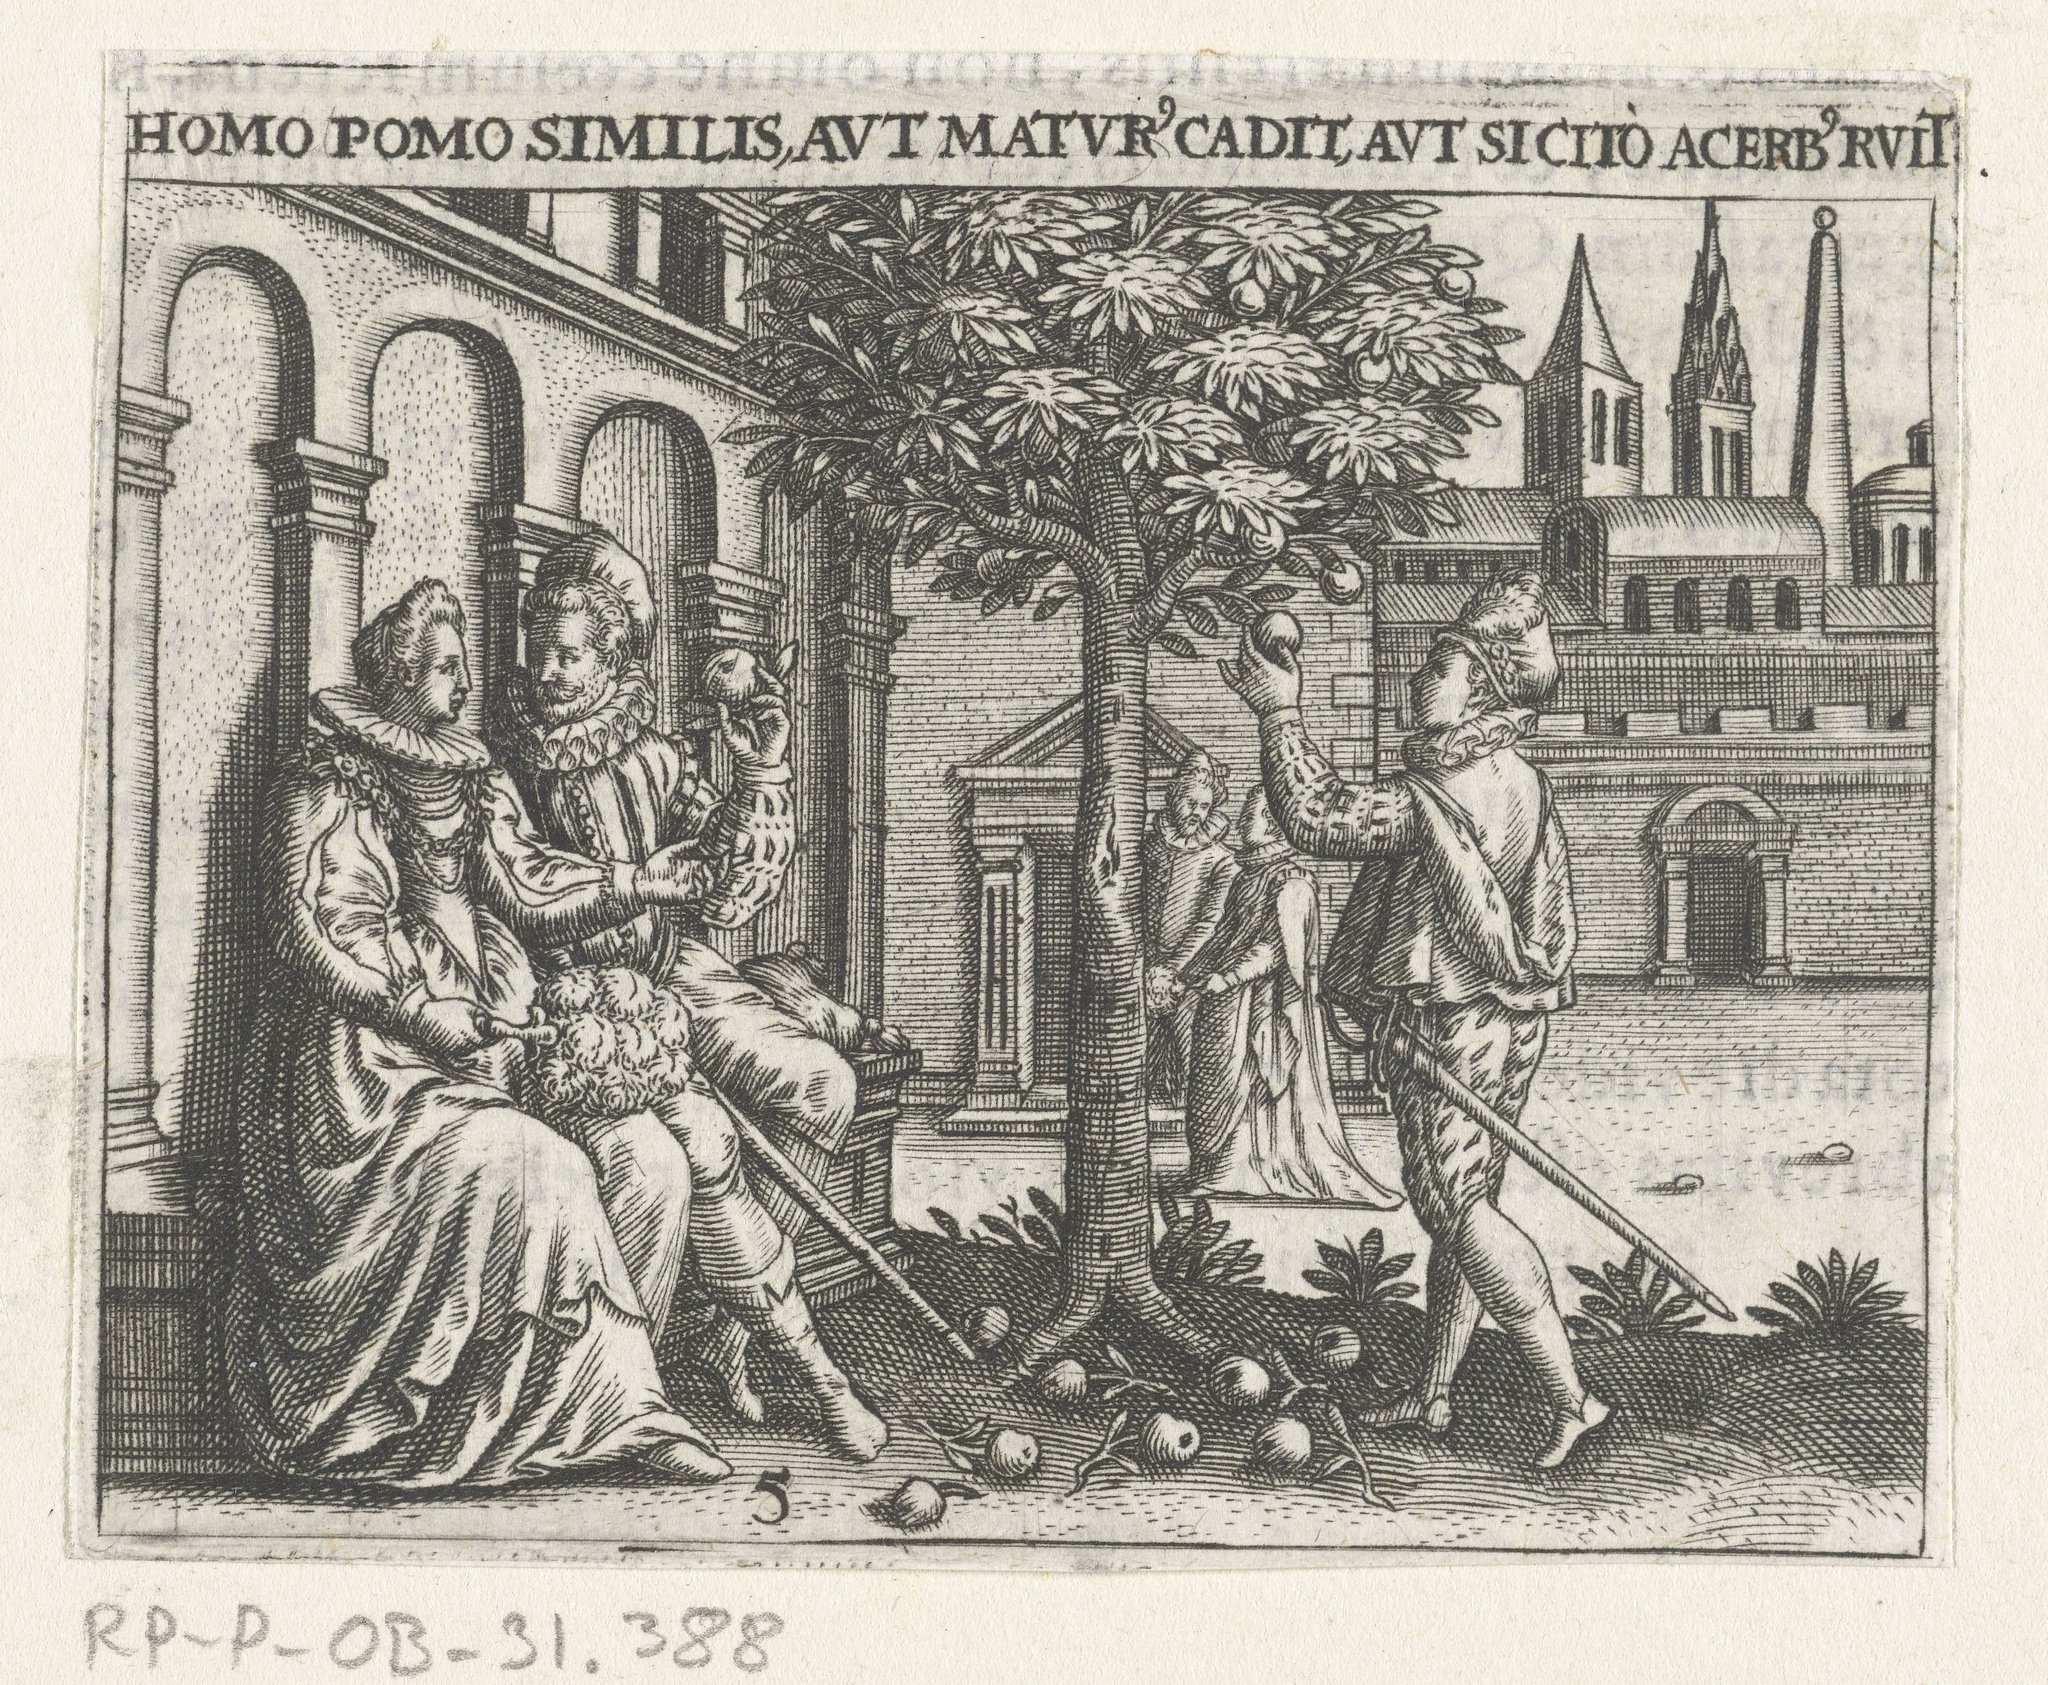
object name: cognizance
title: Denis Lebey de Batilly, Emblemata, 1596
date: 1596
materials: paper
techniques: engraving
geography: frankfurt am main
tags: trees: apple-tree, picking fruit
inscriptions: collector's mark: Lugt 240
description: Een jonge man plukt een appel van een boom. Naast de boom zit een paar op een bankje. De man houdt een appel in zijn hand. Onder de boom liggen ook een paar rijpe appels. Het motto maakt een vergelijking tussen de appel en de mens. Als de appel te vroeg geplukt wordt is hij zuur. Als de appel rijp is valt hij vanzelf uit de boom.